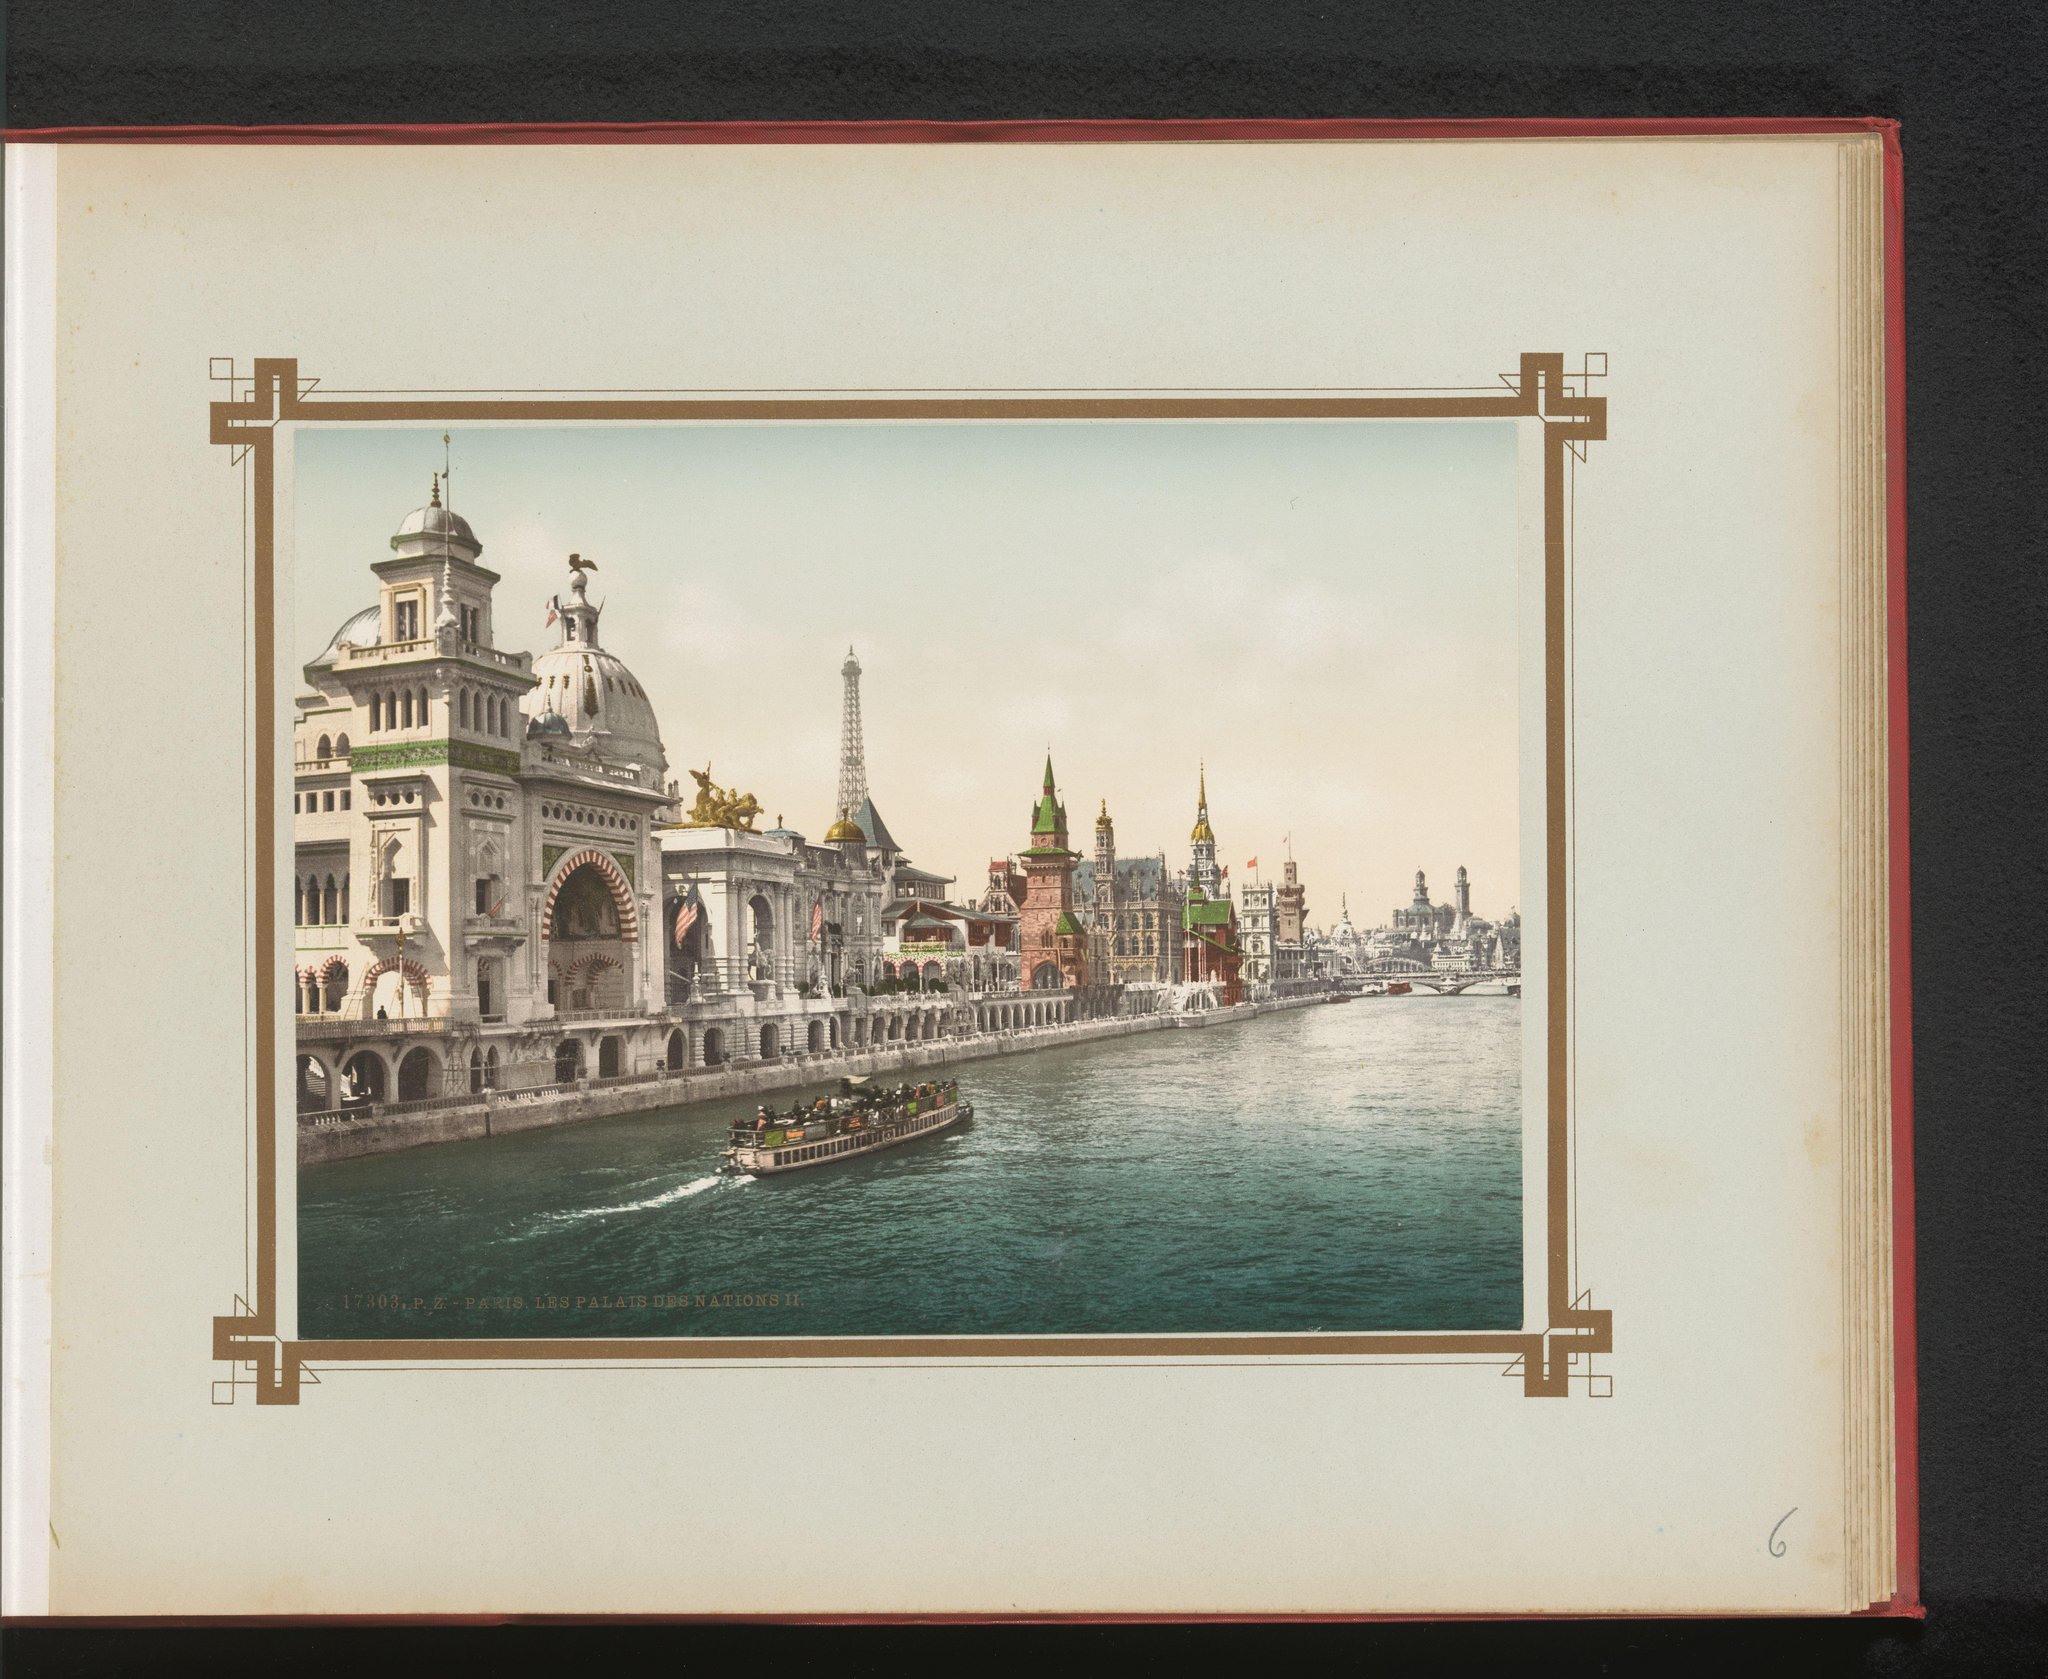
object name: page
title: Gezicht op verschillende paviljoens gezien vanaf de Seine tijdens de Wereldtentoonstelling van 1900 te Parijs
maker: Anonymous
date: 1900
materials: paper, photographic process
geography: paris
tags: river, world fair, world exhibition, civic architecture; edifices; dwellings, paris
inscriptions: inscription: ‘17303. P.Z. - Paris Les Palais des nations II’